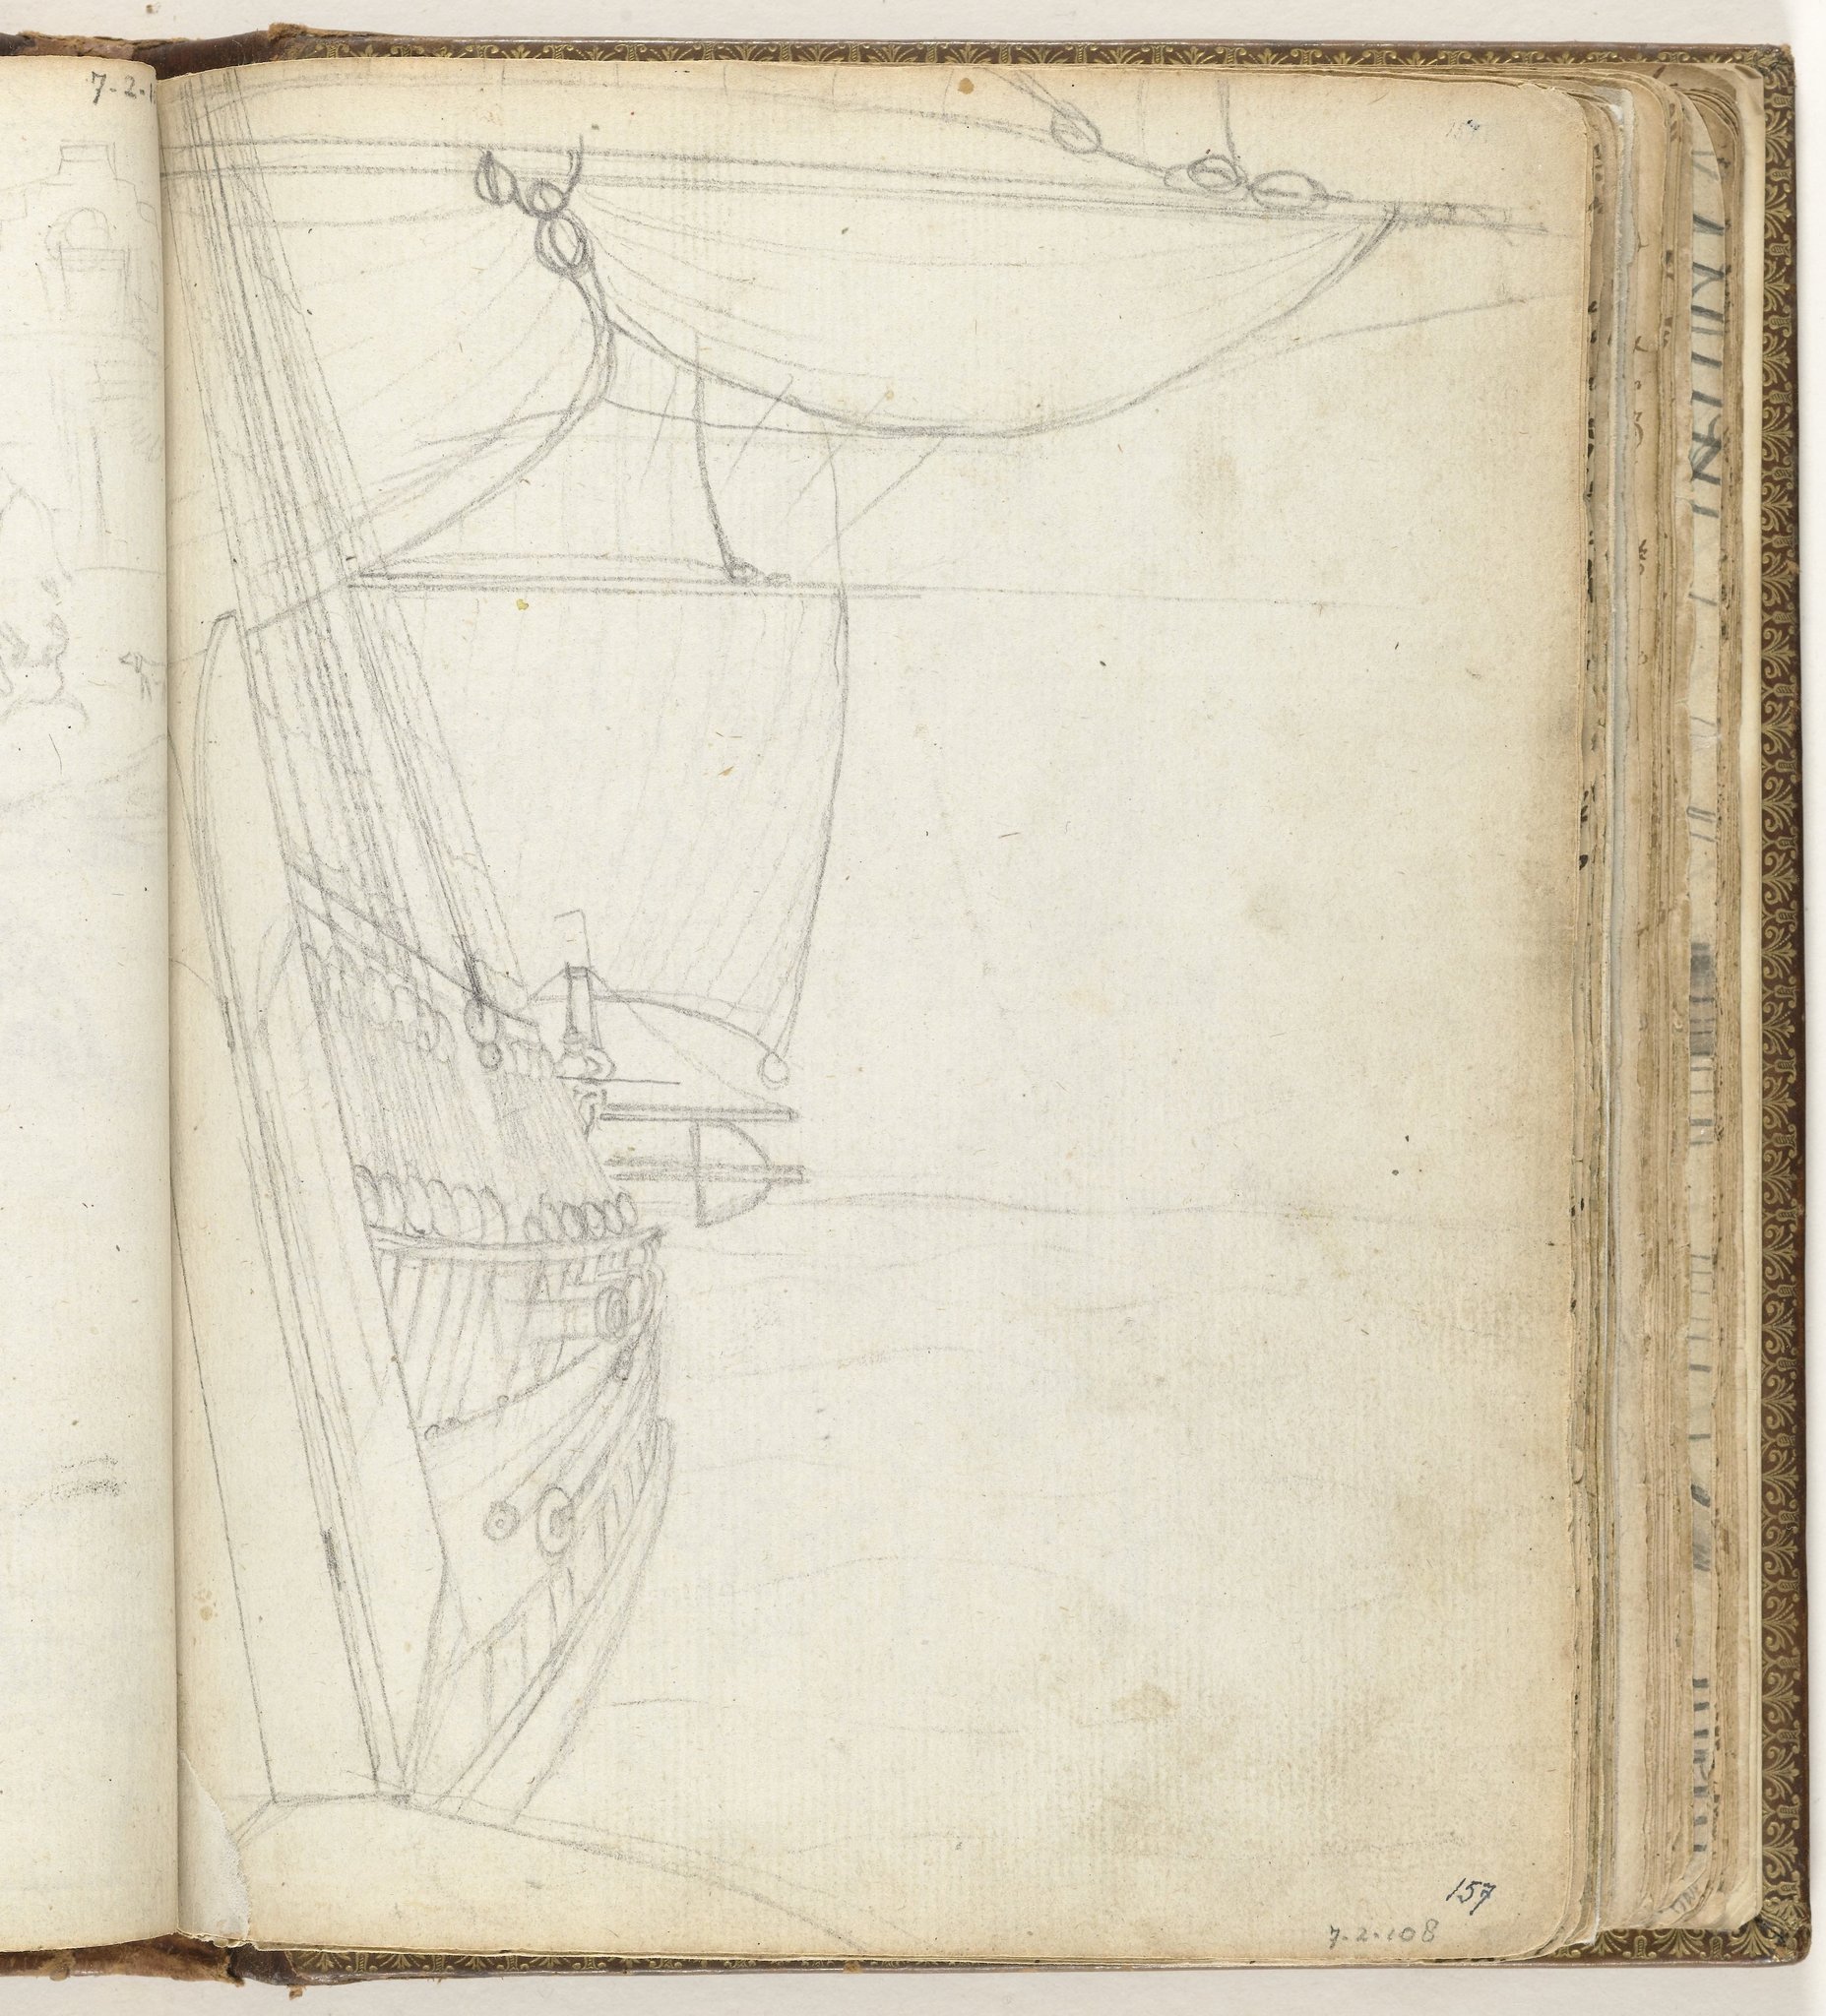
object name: drawing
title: Gezicht uit de gallerij van een Oost-Indiëvaarder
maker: jan brandes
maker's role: draughtsman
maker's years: 1743-1808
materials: paper, pencil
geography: indian ocean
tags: sailing-ship, sailing-boat, parts of ship's exterior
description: Potloodschets van een zeilend schip vanuit de galerij (de plee) naar de boeg. Onderdeel uit het schetsboek van Jan Brandes, dl. 2 (1808), p. 157.